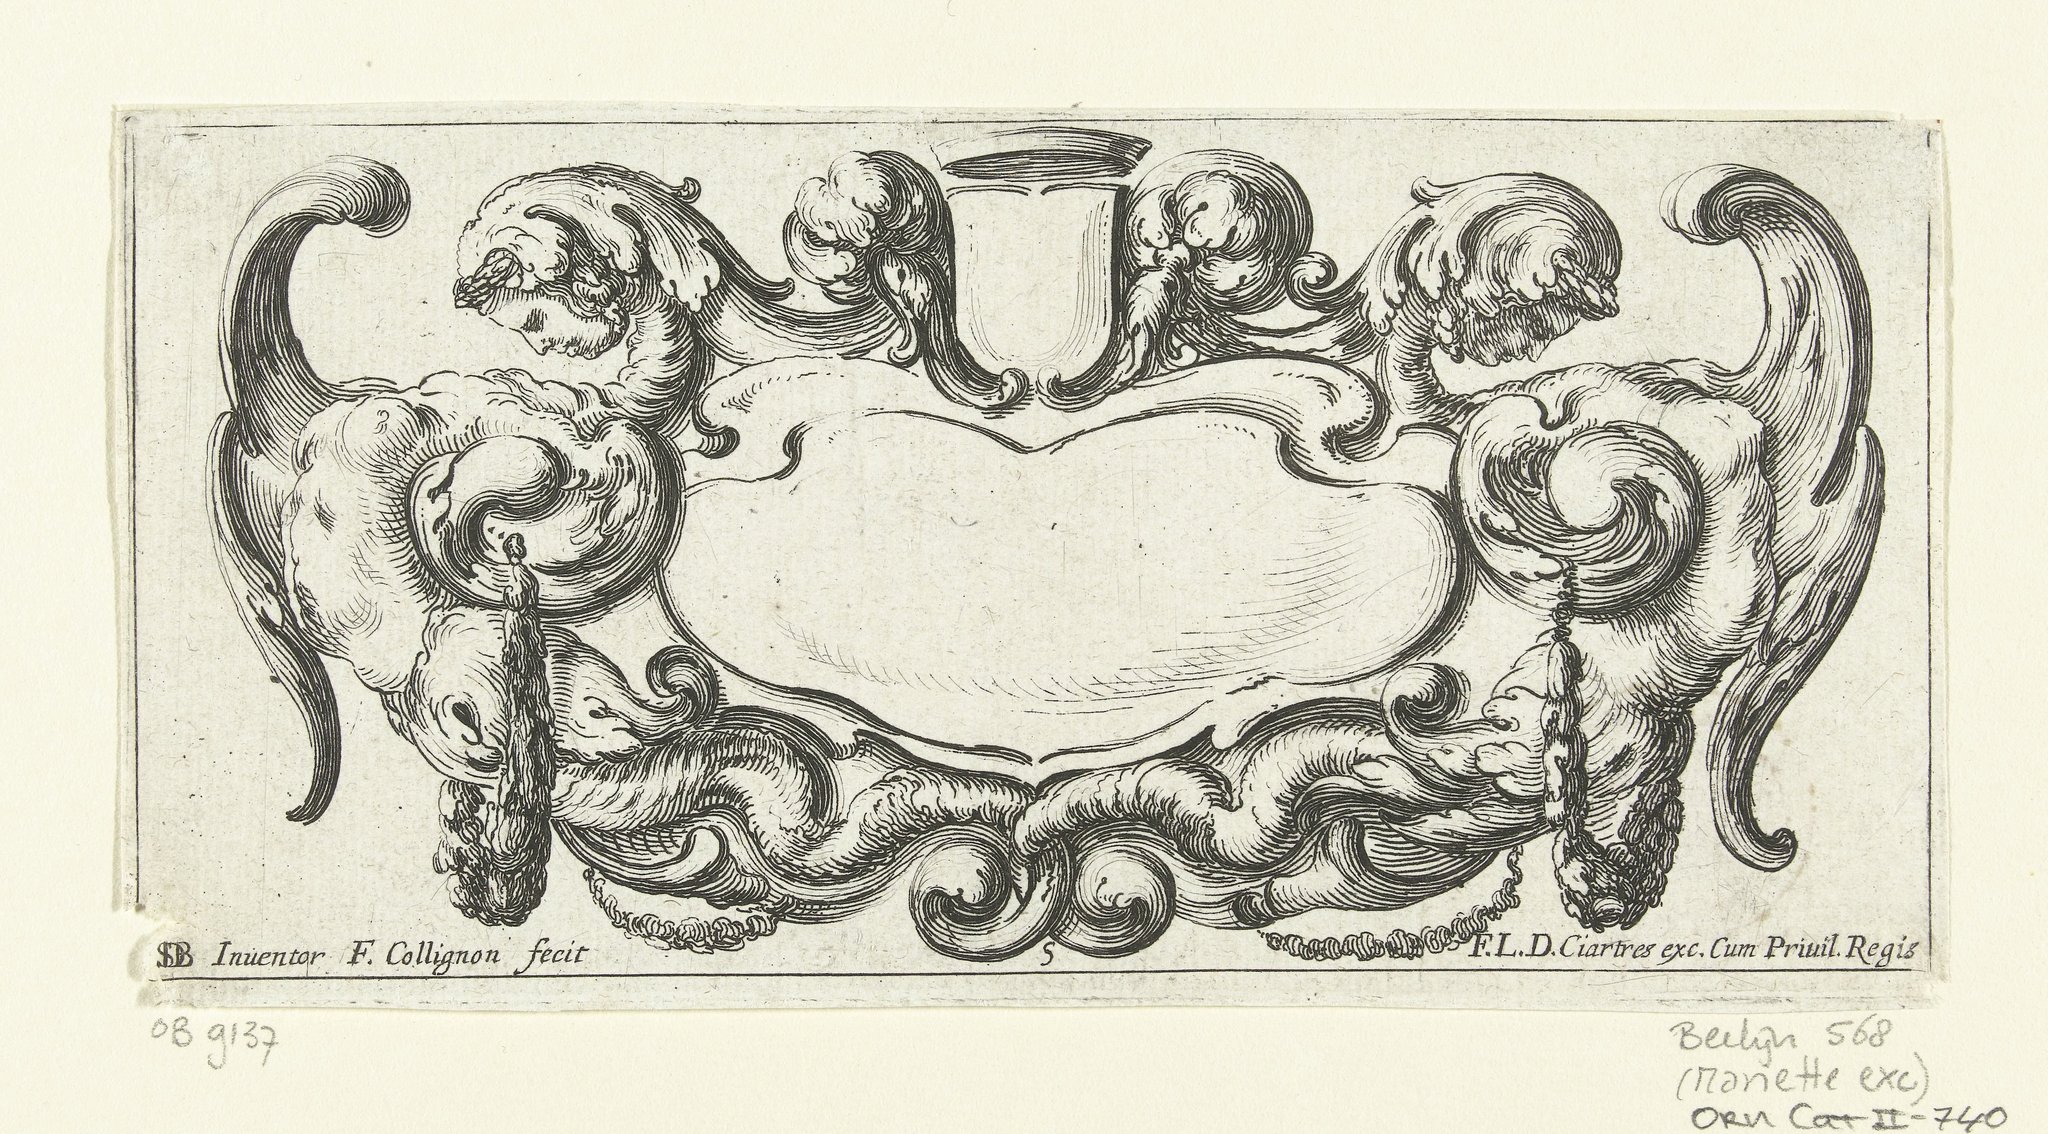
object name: ornament print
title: Cartouche met twee fantastische vrouwelijke figuren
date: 1645-1647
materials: paper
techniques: etching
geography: paris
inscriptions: collector's mark: Lugt 240